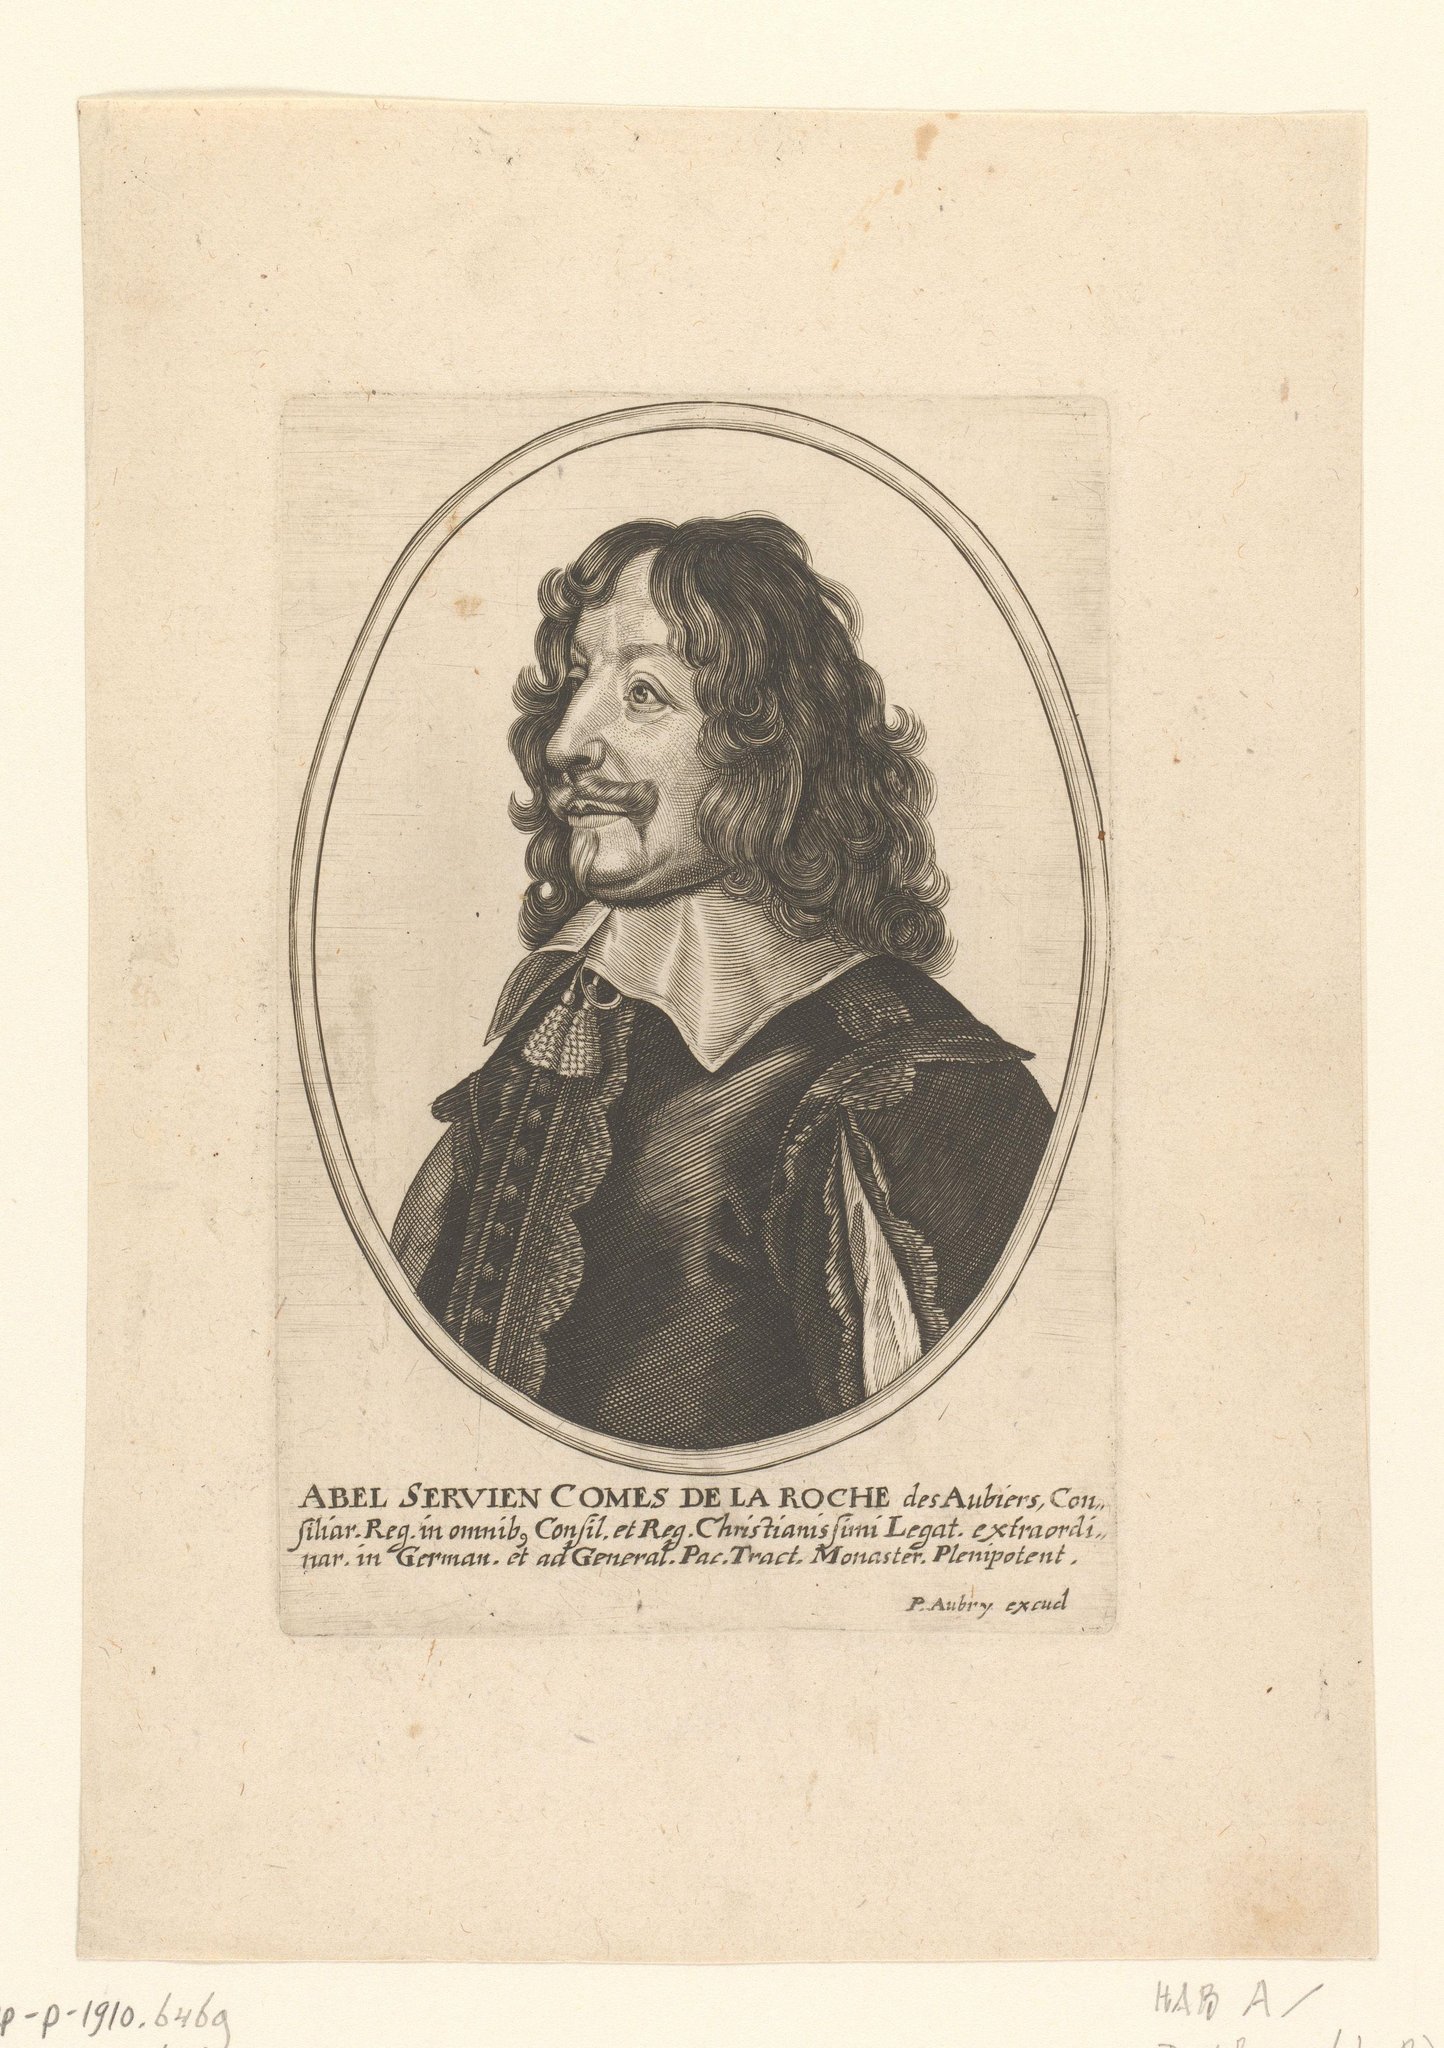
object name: print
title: Portret van Abel de Servien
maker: Anonymous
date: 1648-1650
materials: paper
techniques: engraving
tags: historical persons, diplomacy, diplomat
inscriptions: number: ‘2’, collector's mark: Lugt 2228